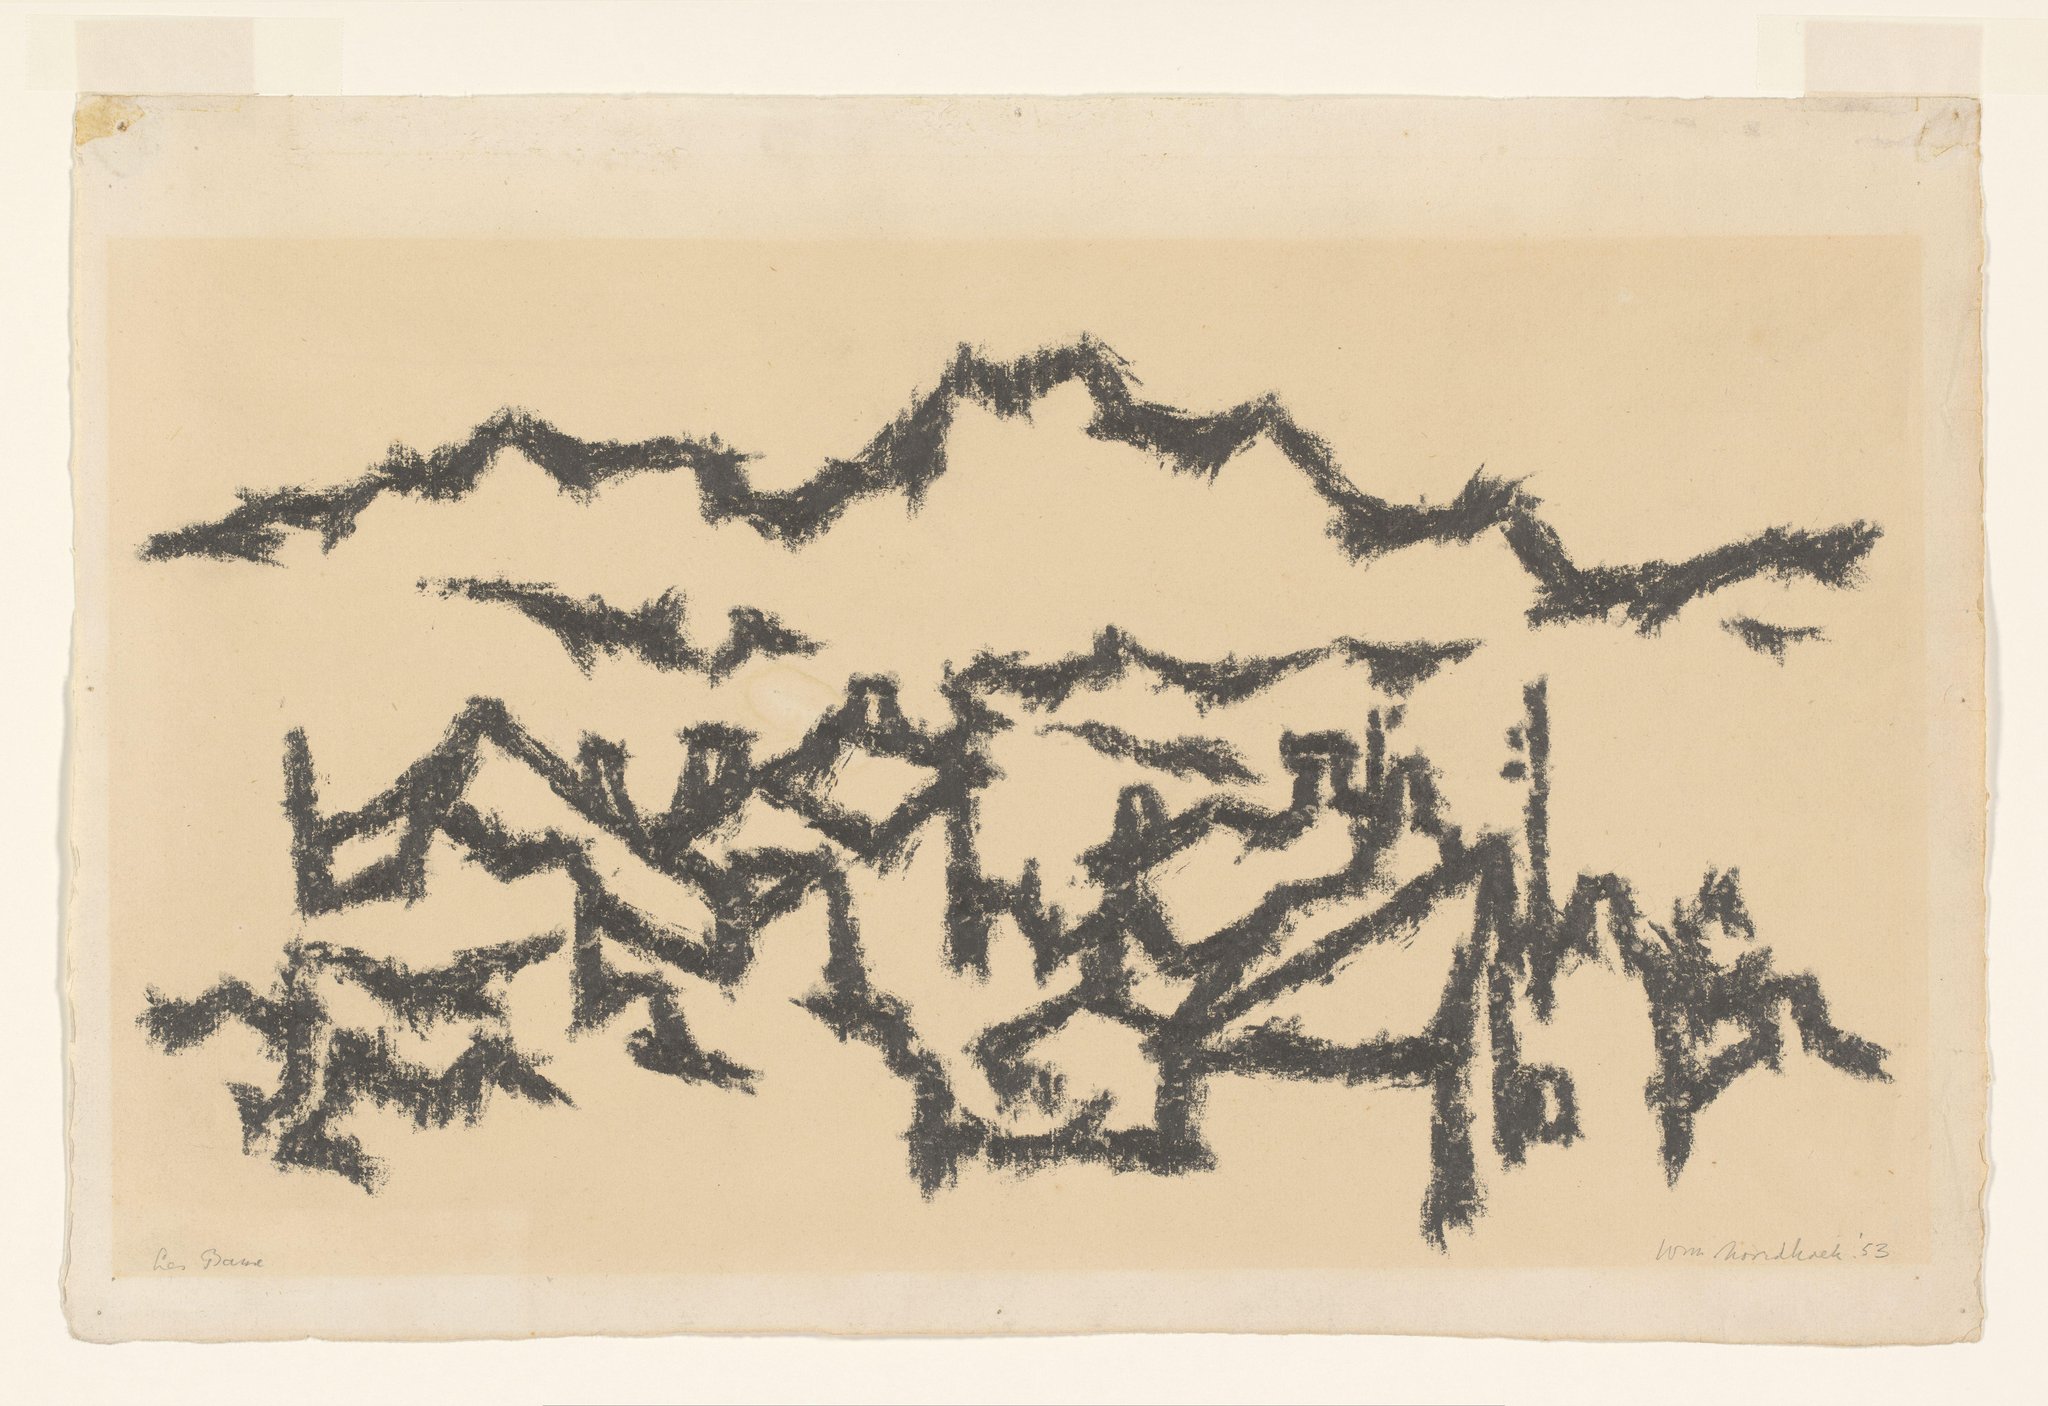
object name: print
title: Pieter Holstein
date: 1970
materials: paper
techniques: etching, intaglio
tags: print maker, frank lodeizen, draughtsman, pieter holstein, portrait, self-portrait of graphic artist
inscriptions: edition: ‘2/12’, signature: ‘frank lodeizen’, title: ‘Pieter Holstein’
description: Links een portret van een man met teneergeslagen ogen en snor, rechts naakte vrouwen op de buitenkant van een vaas.